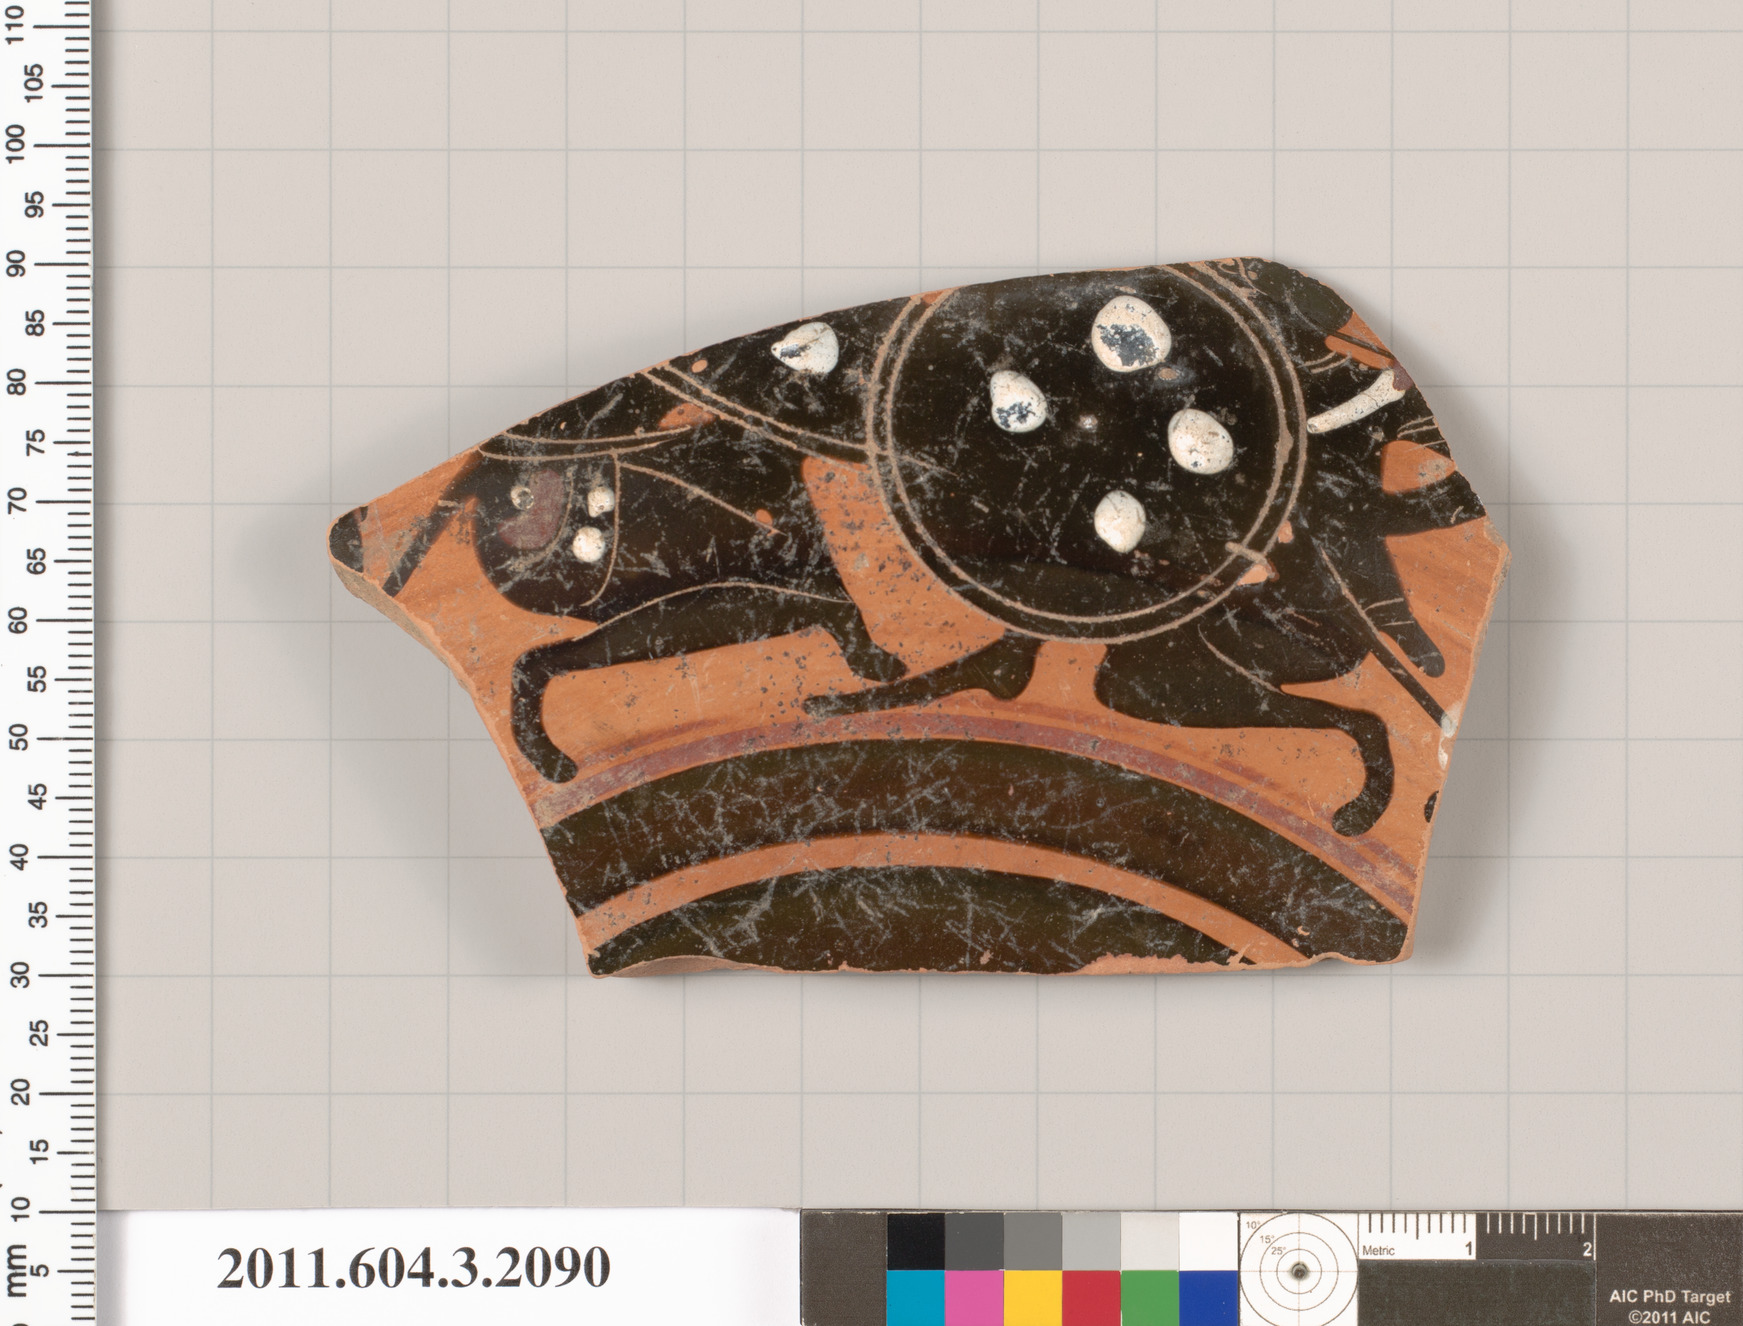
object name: kylix fragment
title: Terracotta fragment of a kylix (drinking cup)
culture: greek, attic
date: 534-468 BCE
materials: terracotta